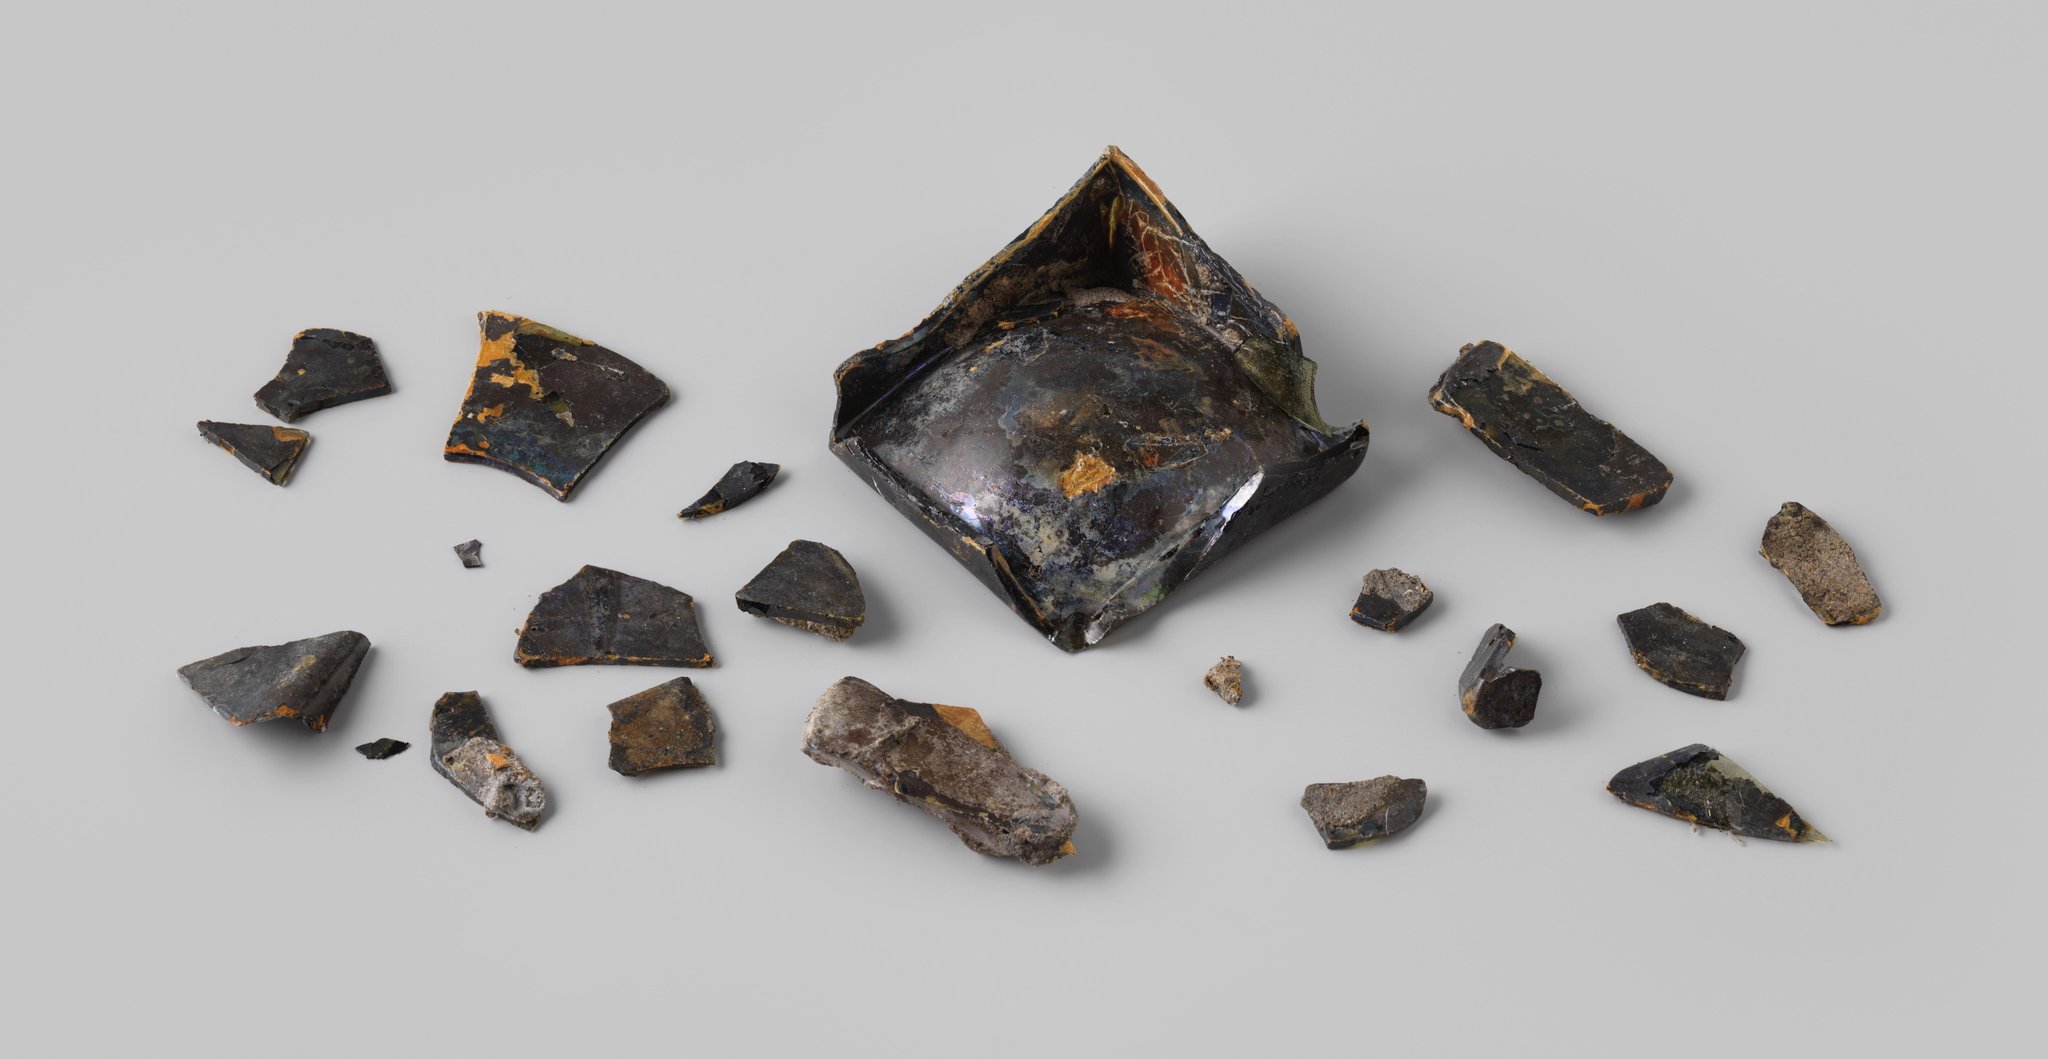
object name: sherd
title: Scherven van kelderflessen uit het wrak van de Oost-Indiëvaarder 't Vliegend Hart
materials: glass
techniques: green glass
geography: middelburg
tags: 't vliegend hart (schip), verenigde oostindische compagnie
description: Fragmenten van vierkante kelderflessen: vierkante bodem met restant van de buik en een aantal losse scherven. Het oorspronkelijk groene glas is in vele kleuren verkleurd. Case bottle.